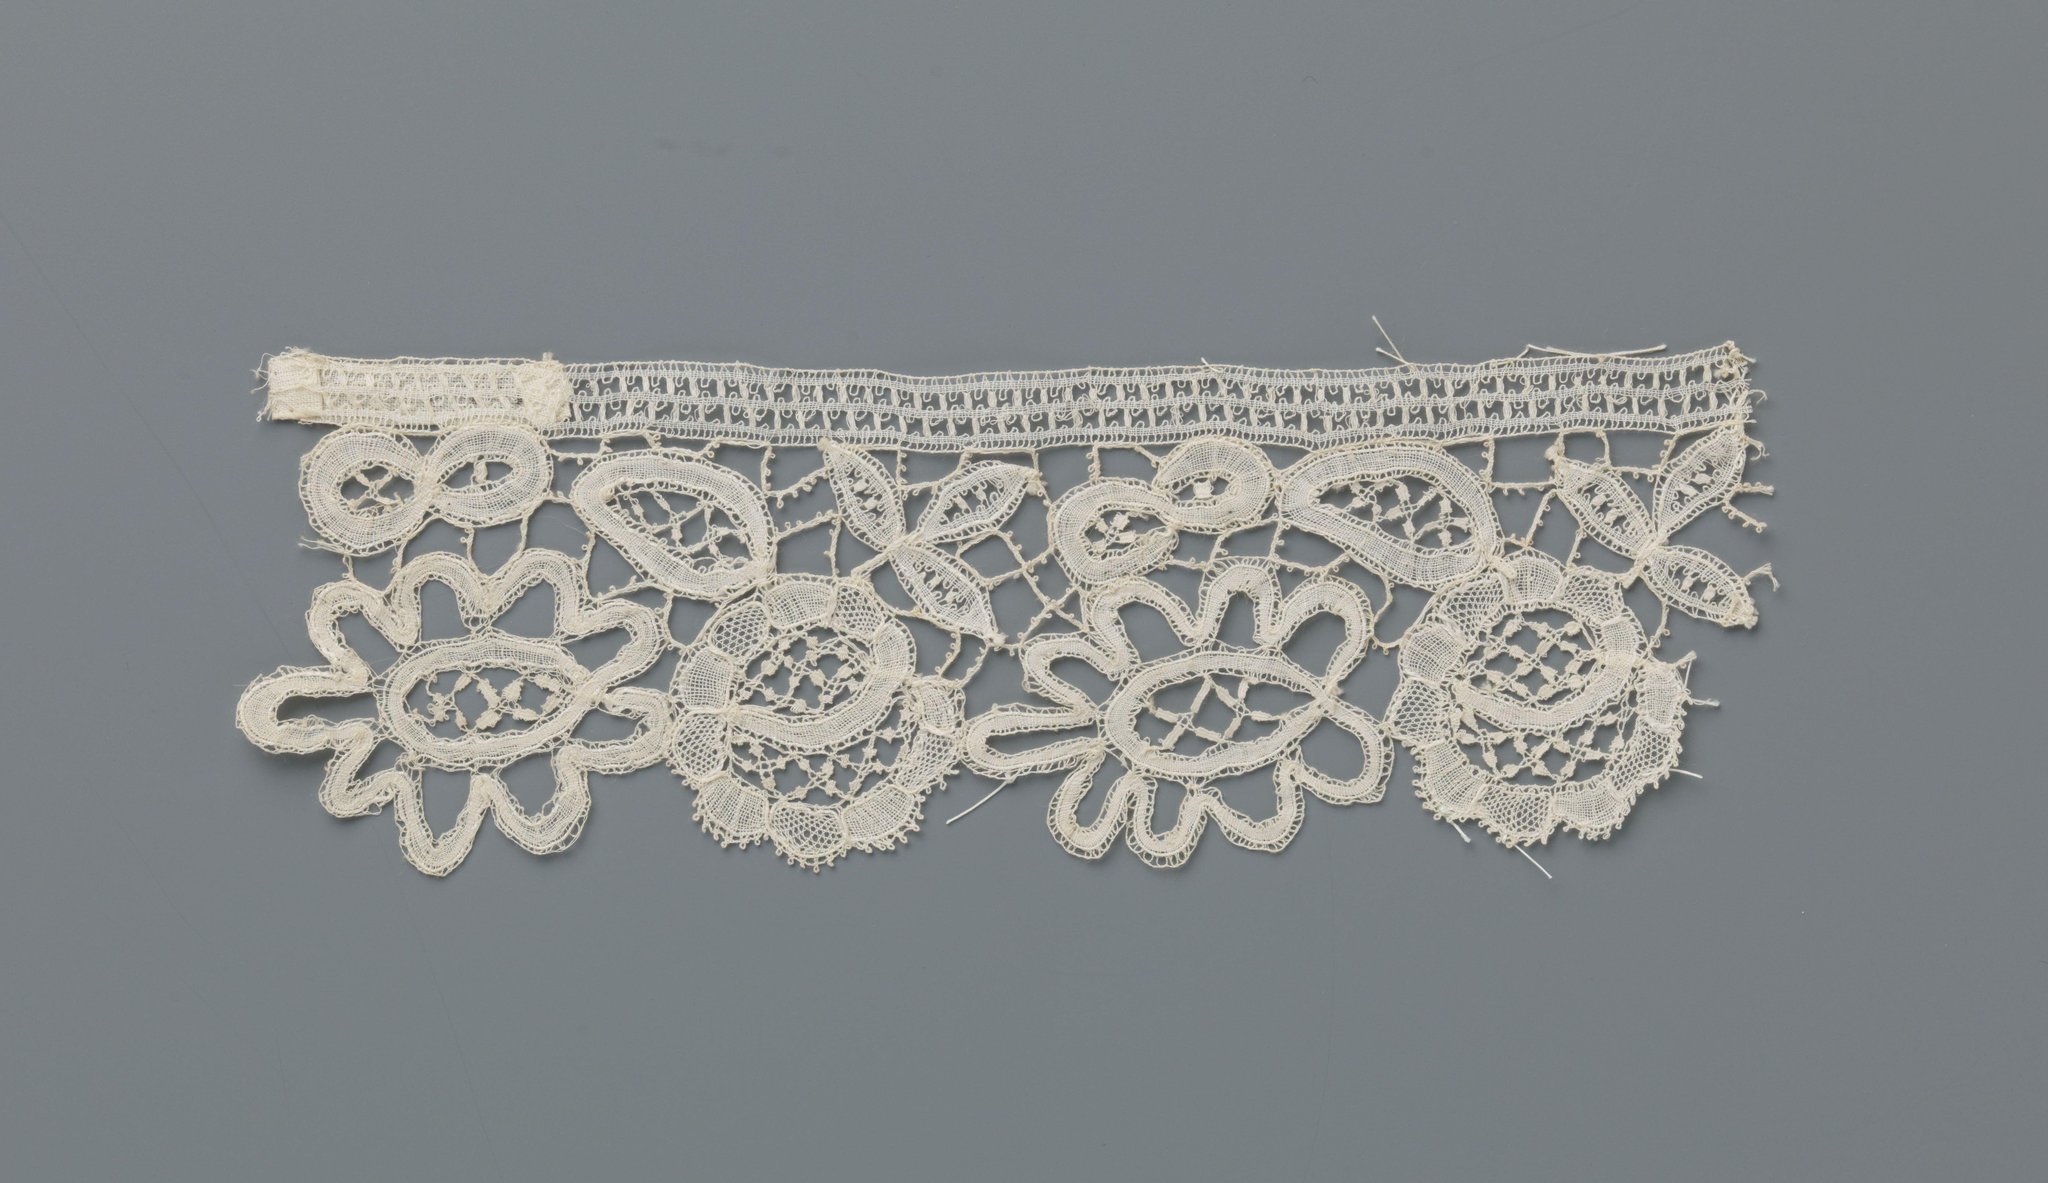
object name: strip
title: Strook kloskant met afwisselend een roos en een ovale bloem met negen lobben als bloembladeren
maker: Anonymous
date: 1900-1915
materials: linen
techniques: lace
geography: honiton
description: Strook naturelkleurige kloskant: Honiton-kant. Het zich herhalende patroon bestaat langs de onderzijde van de strook afwisselend uit een roos en een bloem met negen opengewerkte lobben als bloembladeren om een ovaal bloemhart. Boven deze bloemenrij enkele verschillende bladeren. De contouren van de motieven zijn gemaakt in linnenslag met opengewerkte randjes en deels in netslag, met glimmende contourdraden. Binnen de contouren in linnen- en netslag zijn siervullingen toegepast in vormslag. De motieven zijn met elkaar verbonden door een gepicoteerde vlechtengrond. De schulpenrand wordt gevormd door de bloemen en is afgewerkt met picots. De bovenzijde is recht afgewerkt met een apart geklost bandje.